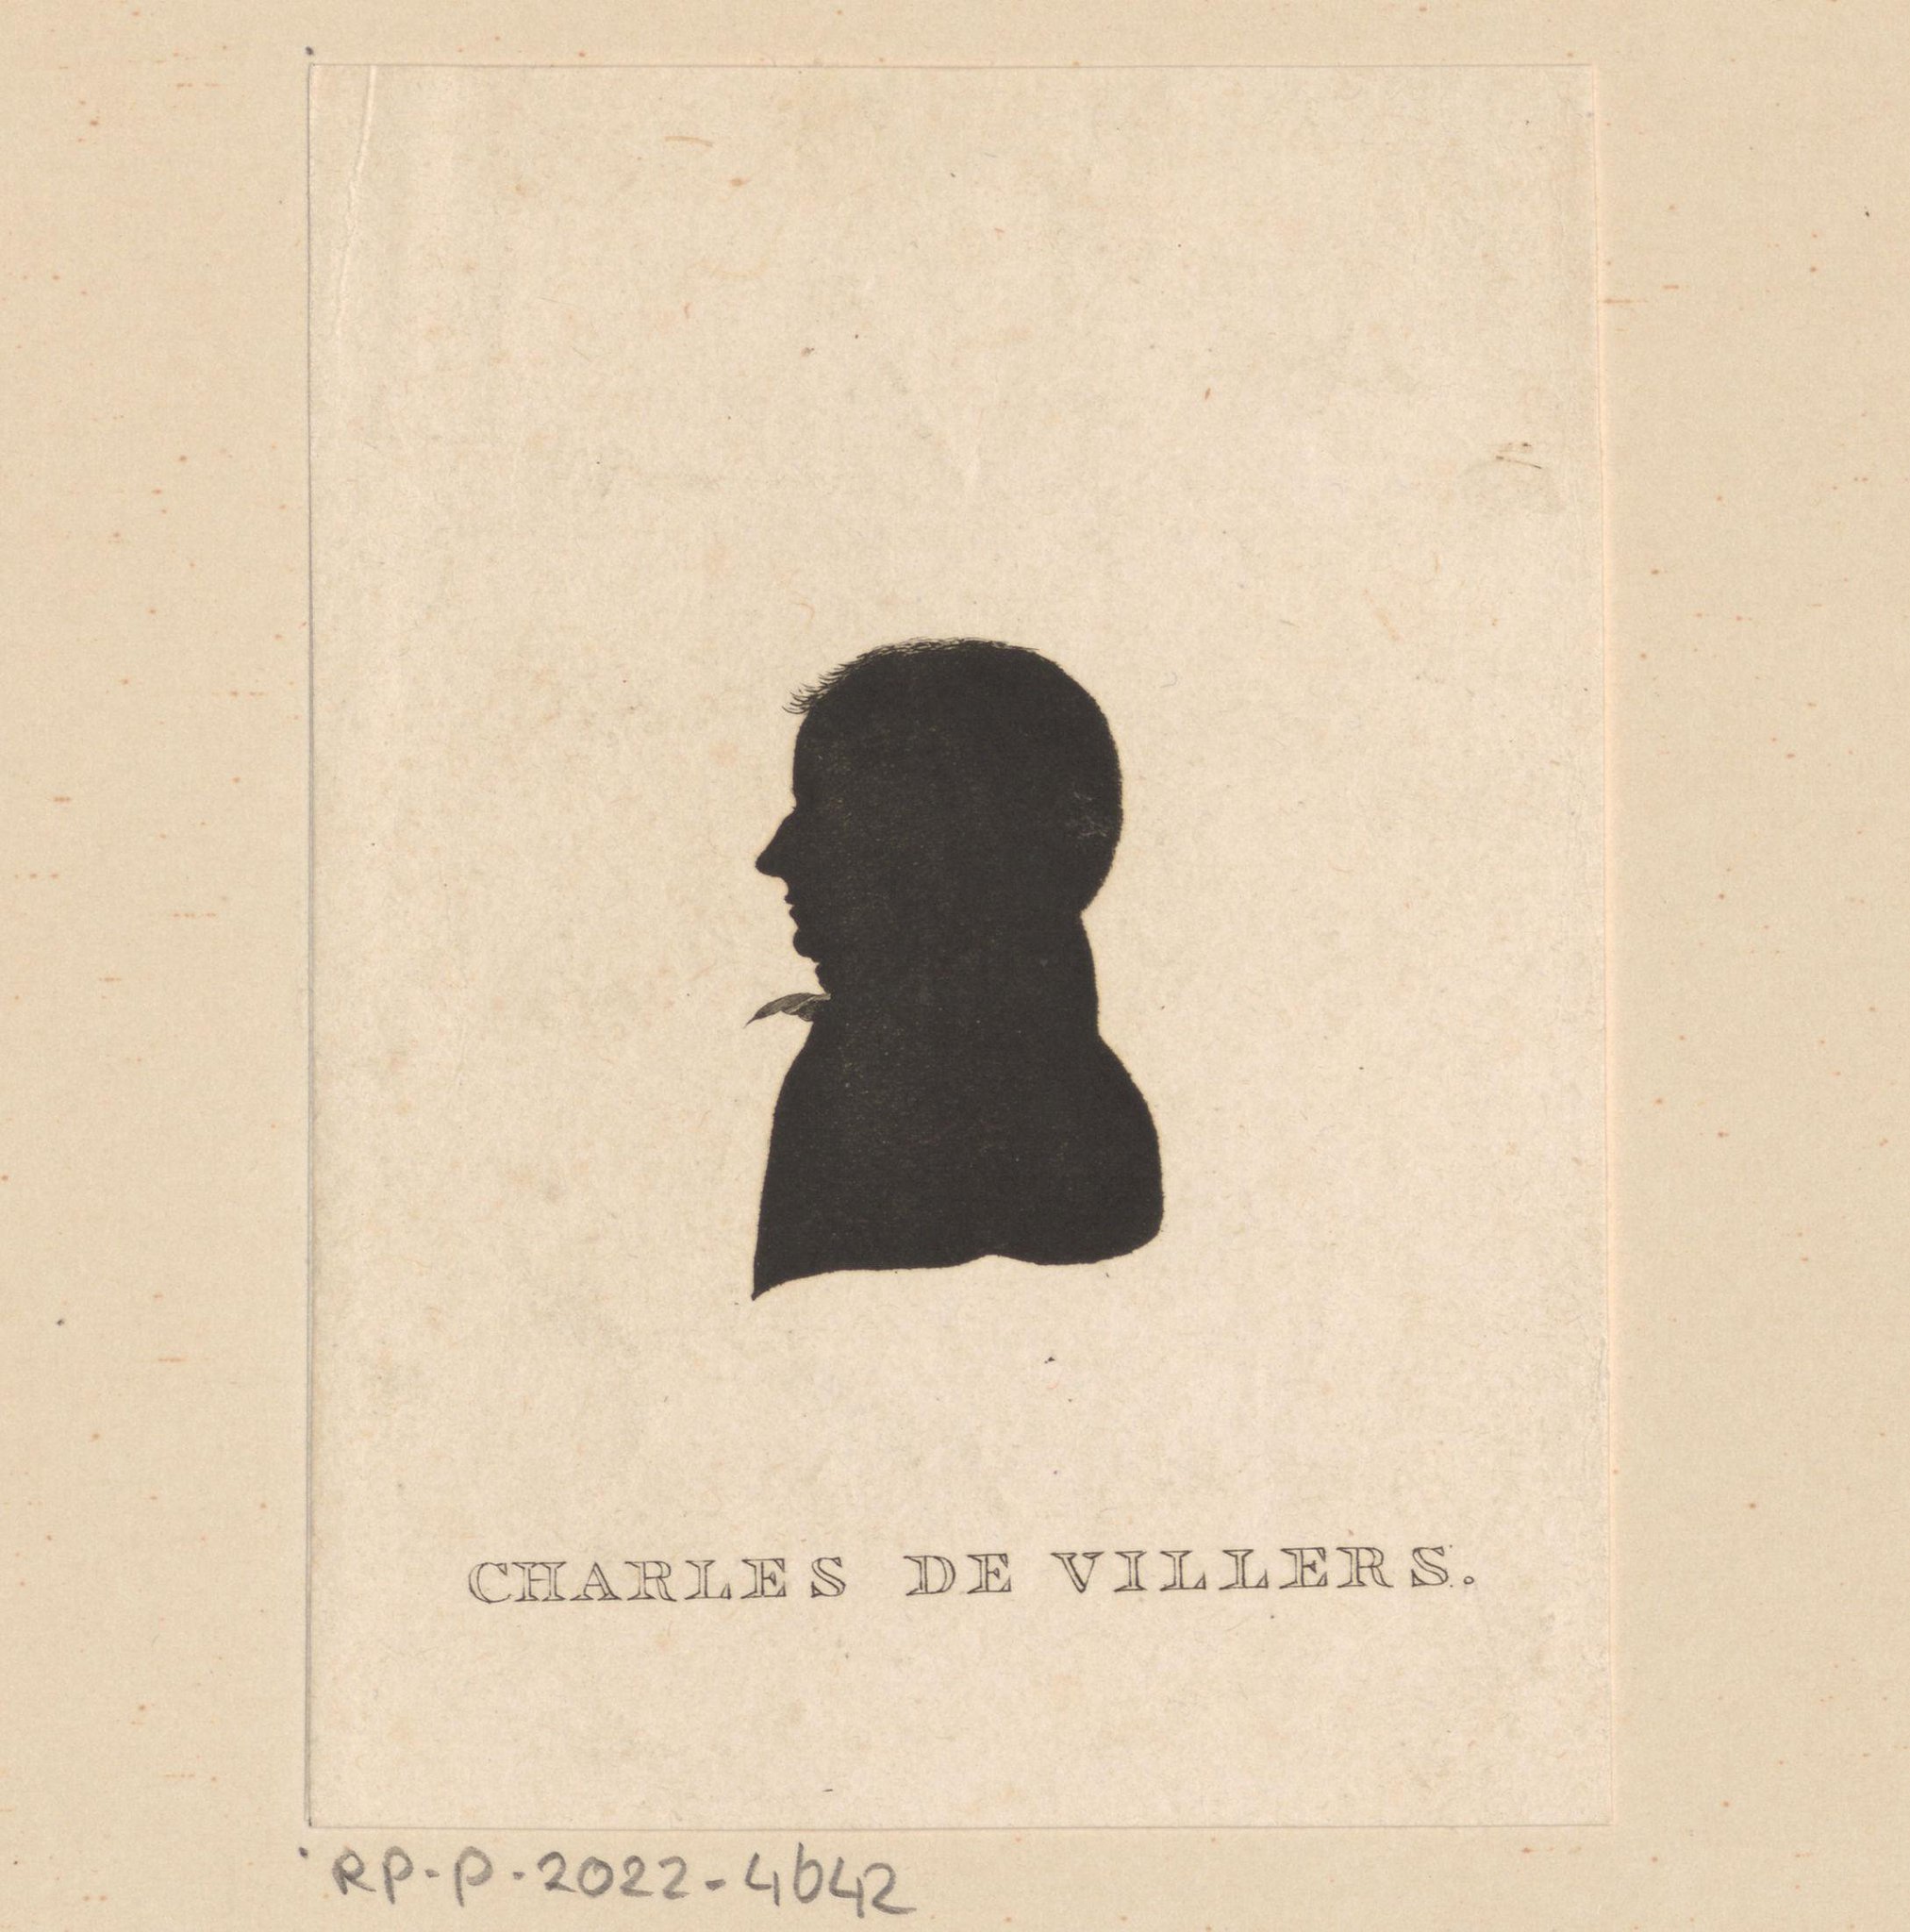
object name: print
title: Silhouetportret van Charles de Villers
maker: Anonymous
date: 1800-1850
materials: paper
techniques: etching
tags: scholar, philosopher, historical persons